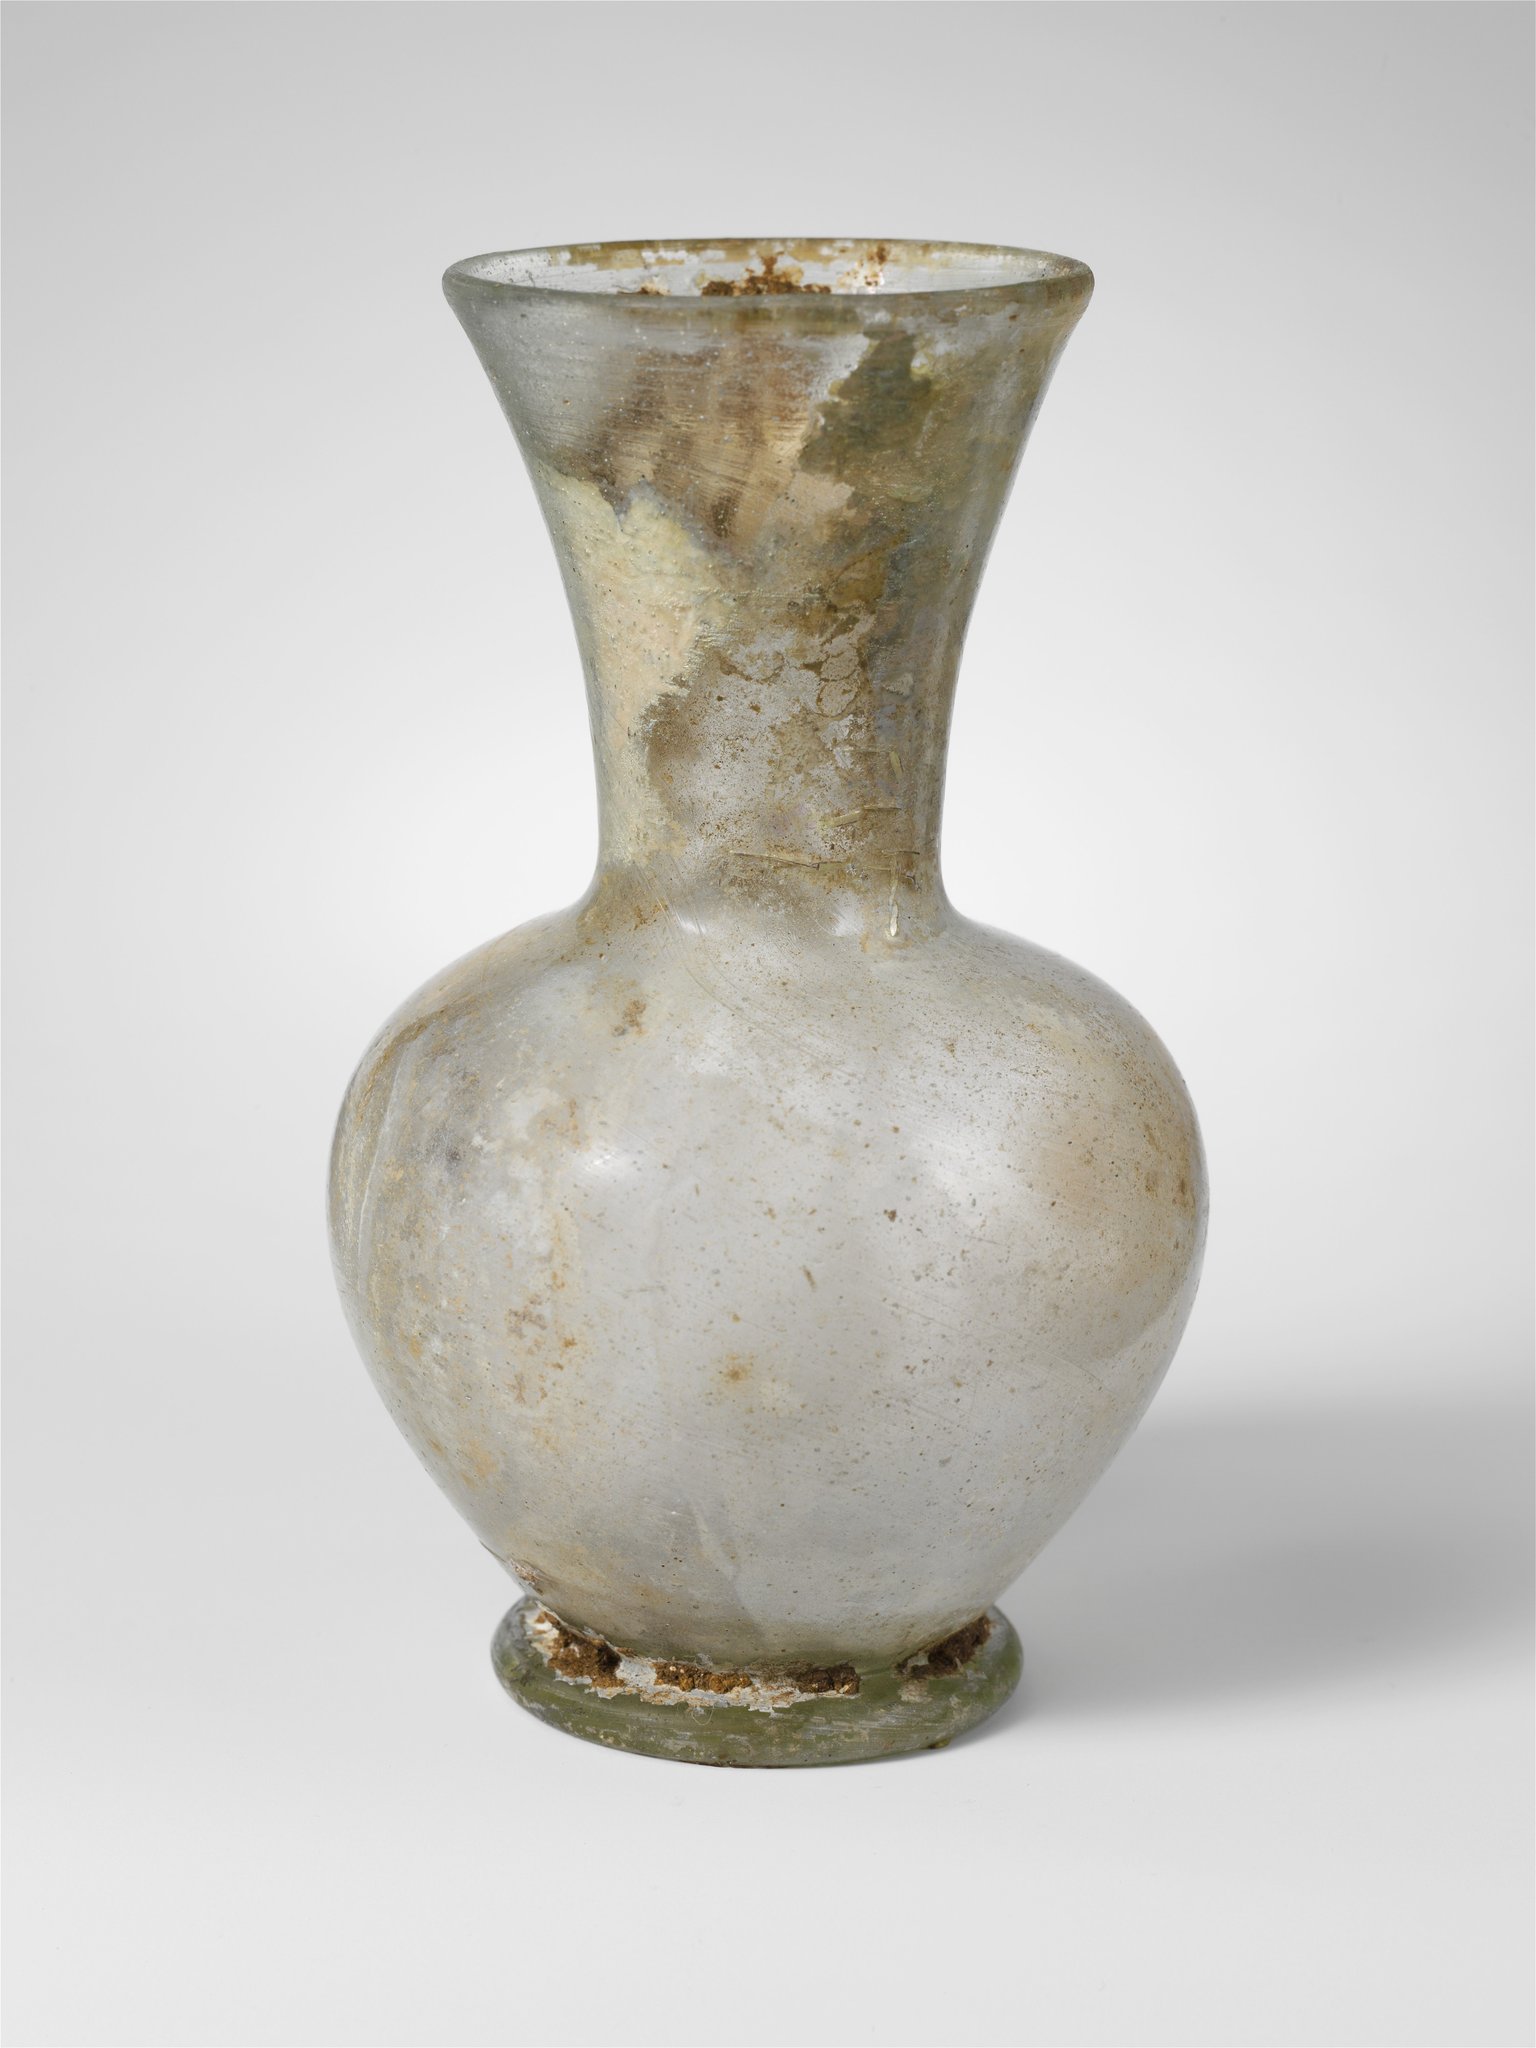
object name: flask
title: Glass flask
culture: roman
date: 301-400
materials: glass